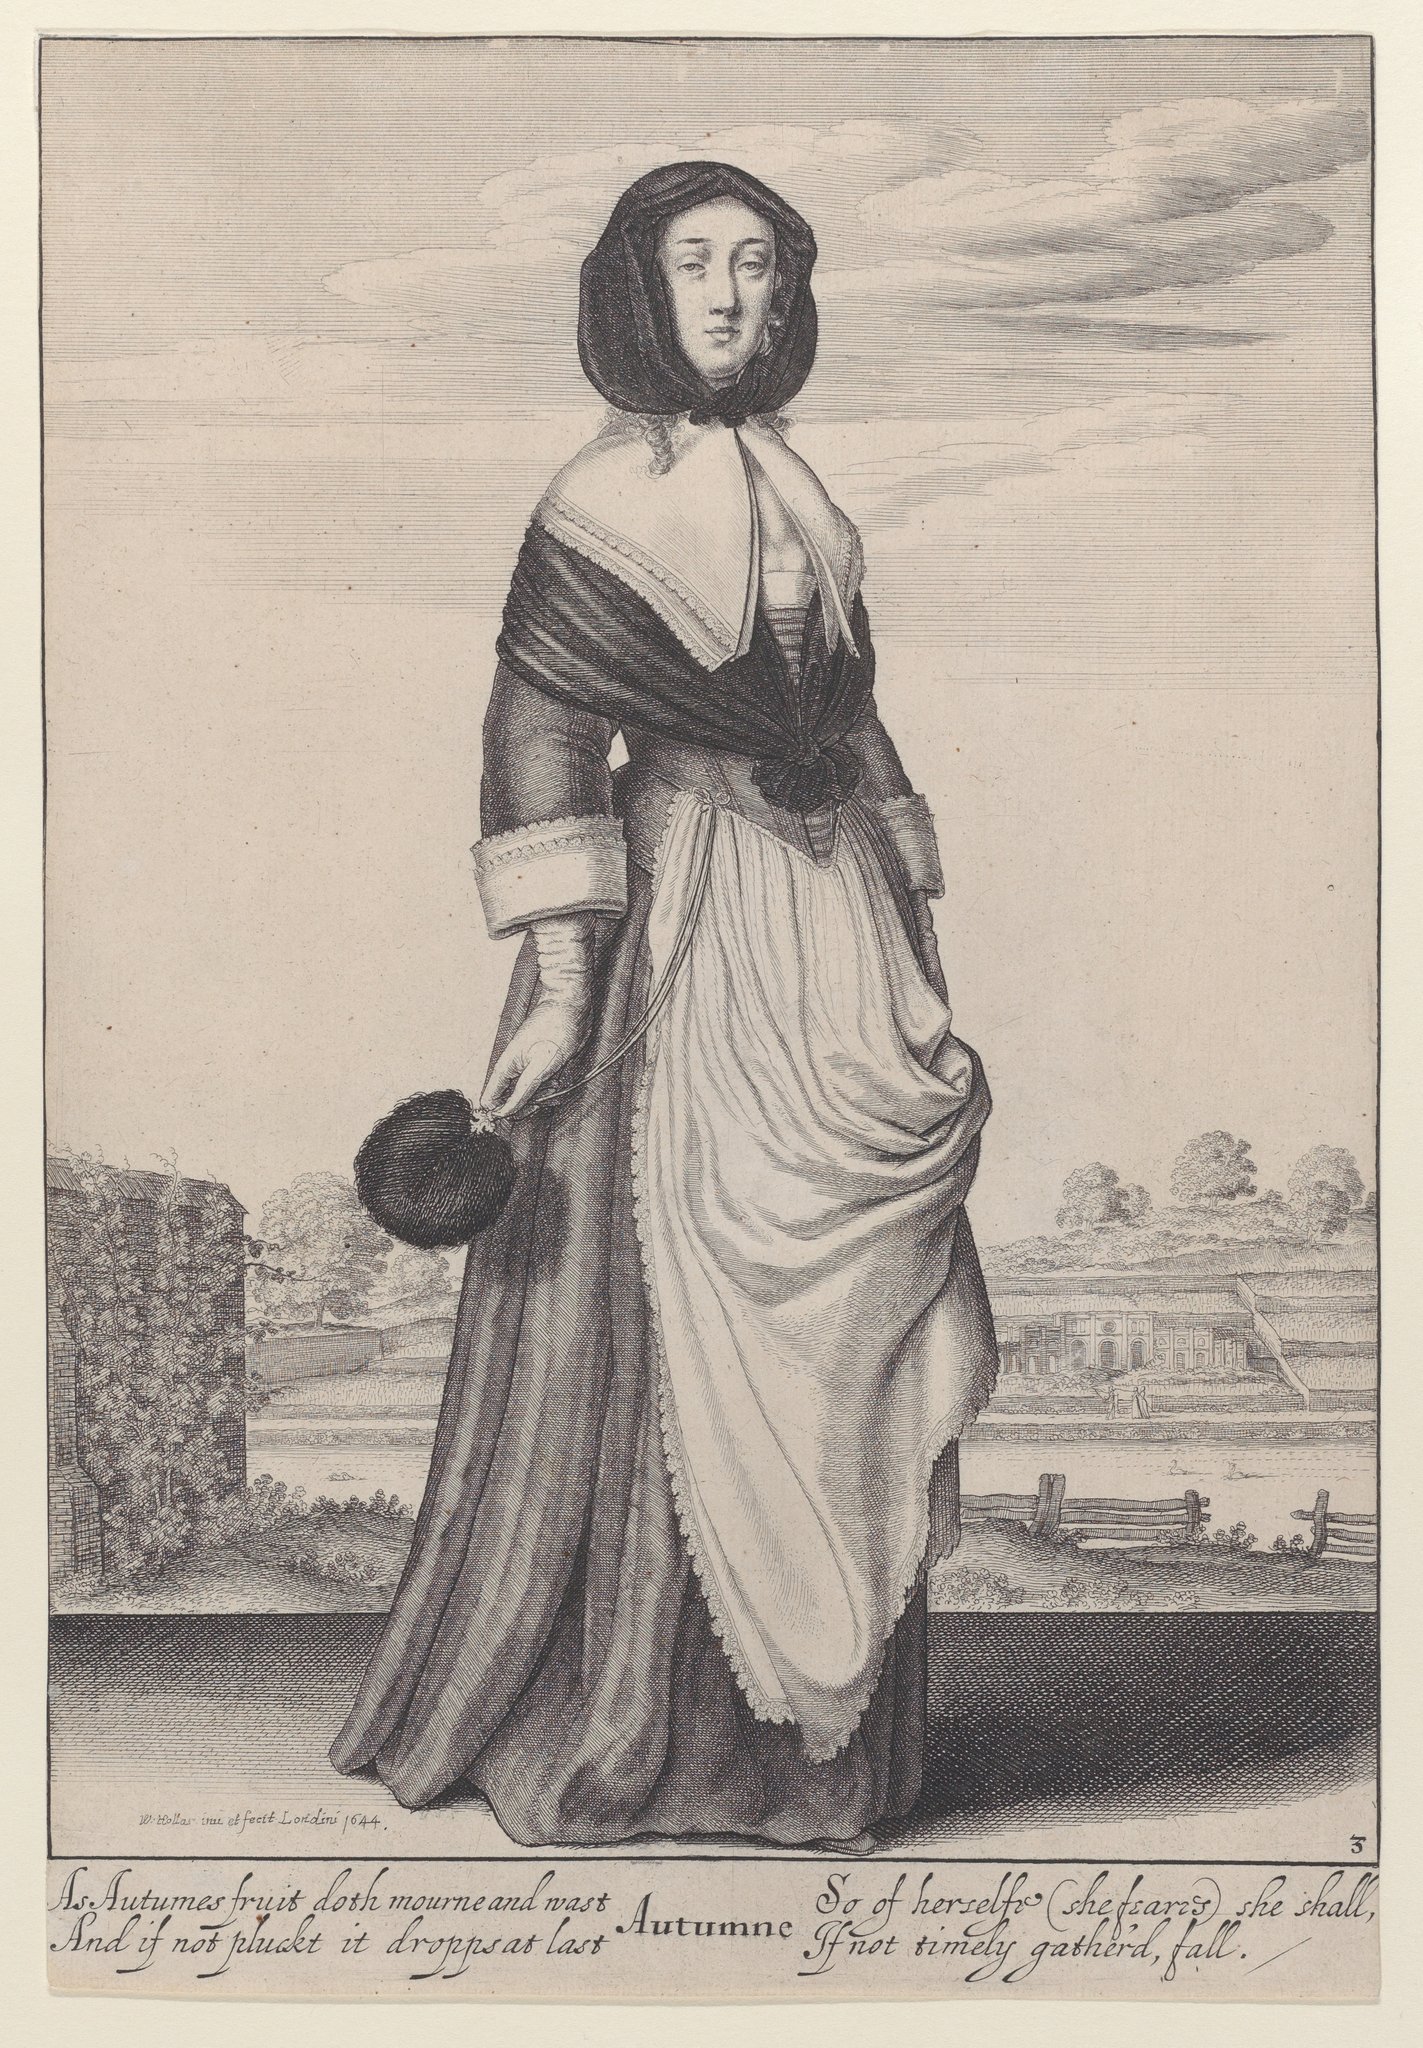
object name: print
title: Autumn, from "Full-Length Seasons"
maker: wenceslaus hollar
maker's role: artist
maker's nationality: bohemian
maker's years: 1607-1677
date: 1643-1644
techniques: etching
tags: women